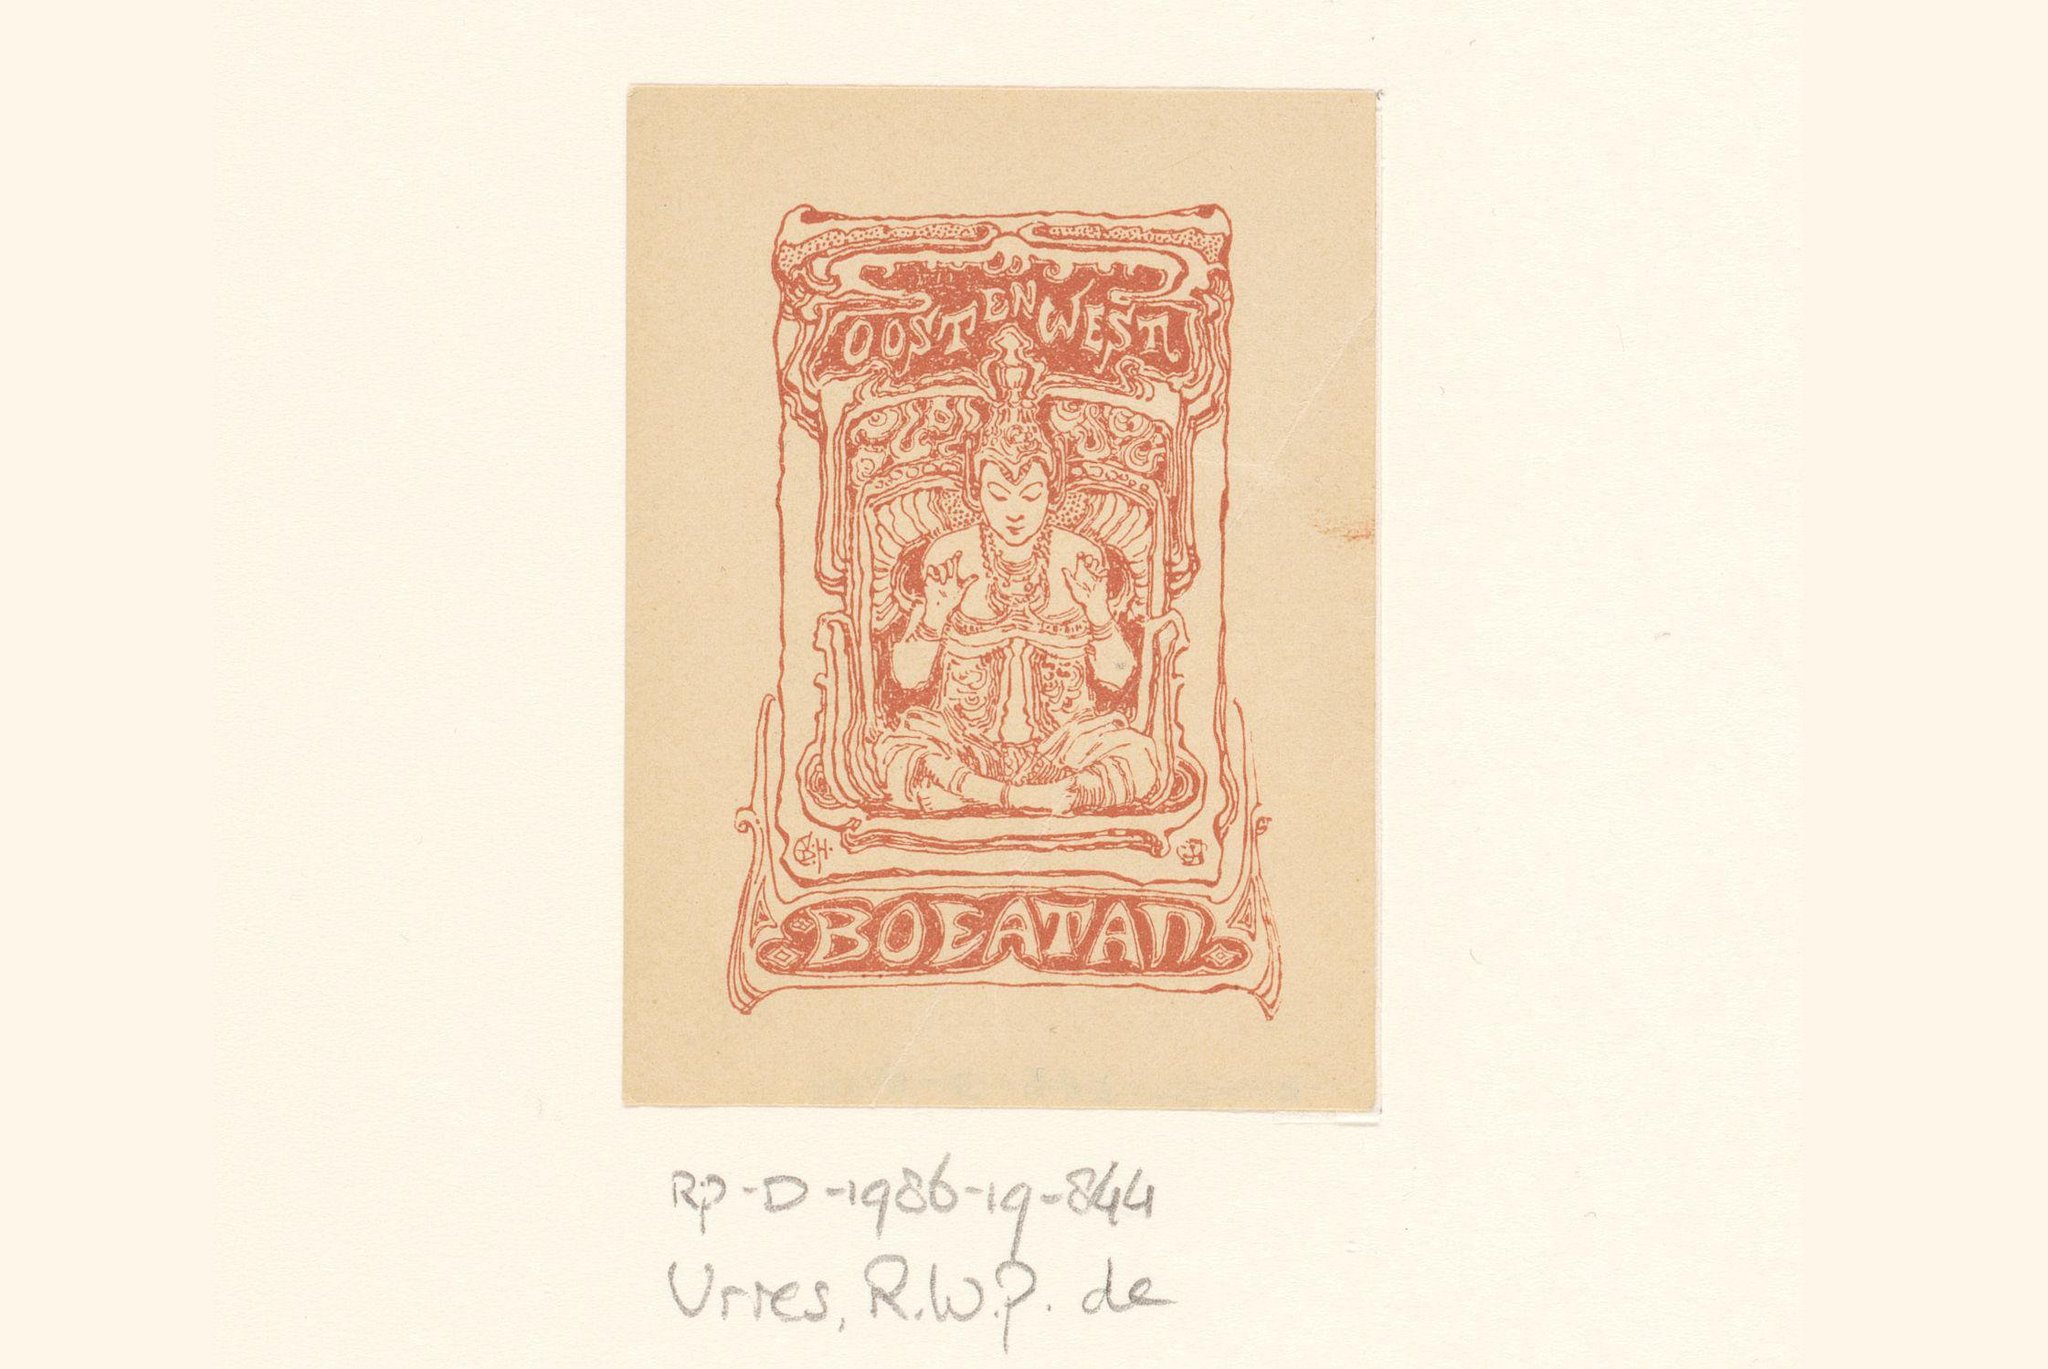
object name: photomechanical print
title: Beeldmerk van de culturele onderneming Boeatan ('huisarbeid')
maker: cornelia van der hart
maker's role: print maker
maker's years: 1851-1940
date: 1909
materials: paper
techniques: printing block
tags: buddha, founder of buddhism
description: De culturele onderneming N.V. Boeatan werd in 1903 opgericht in Den Haag vanuit de Vereniging Oost en West (1899) en was zowel een winkel als een eetgelegenheid en tentoonstellingsruimte.